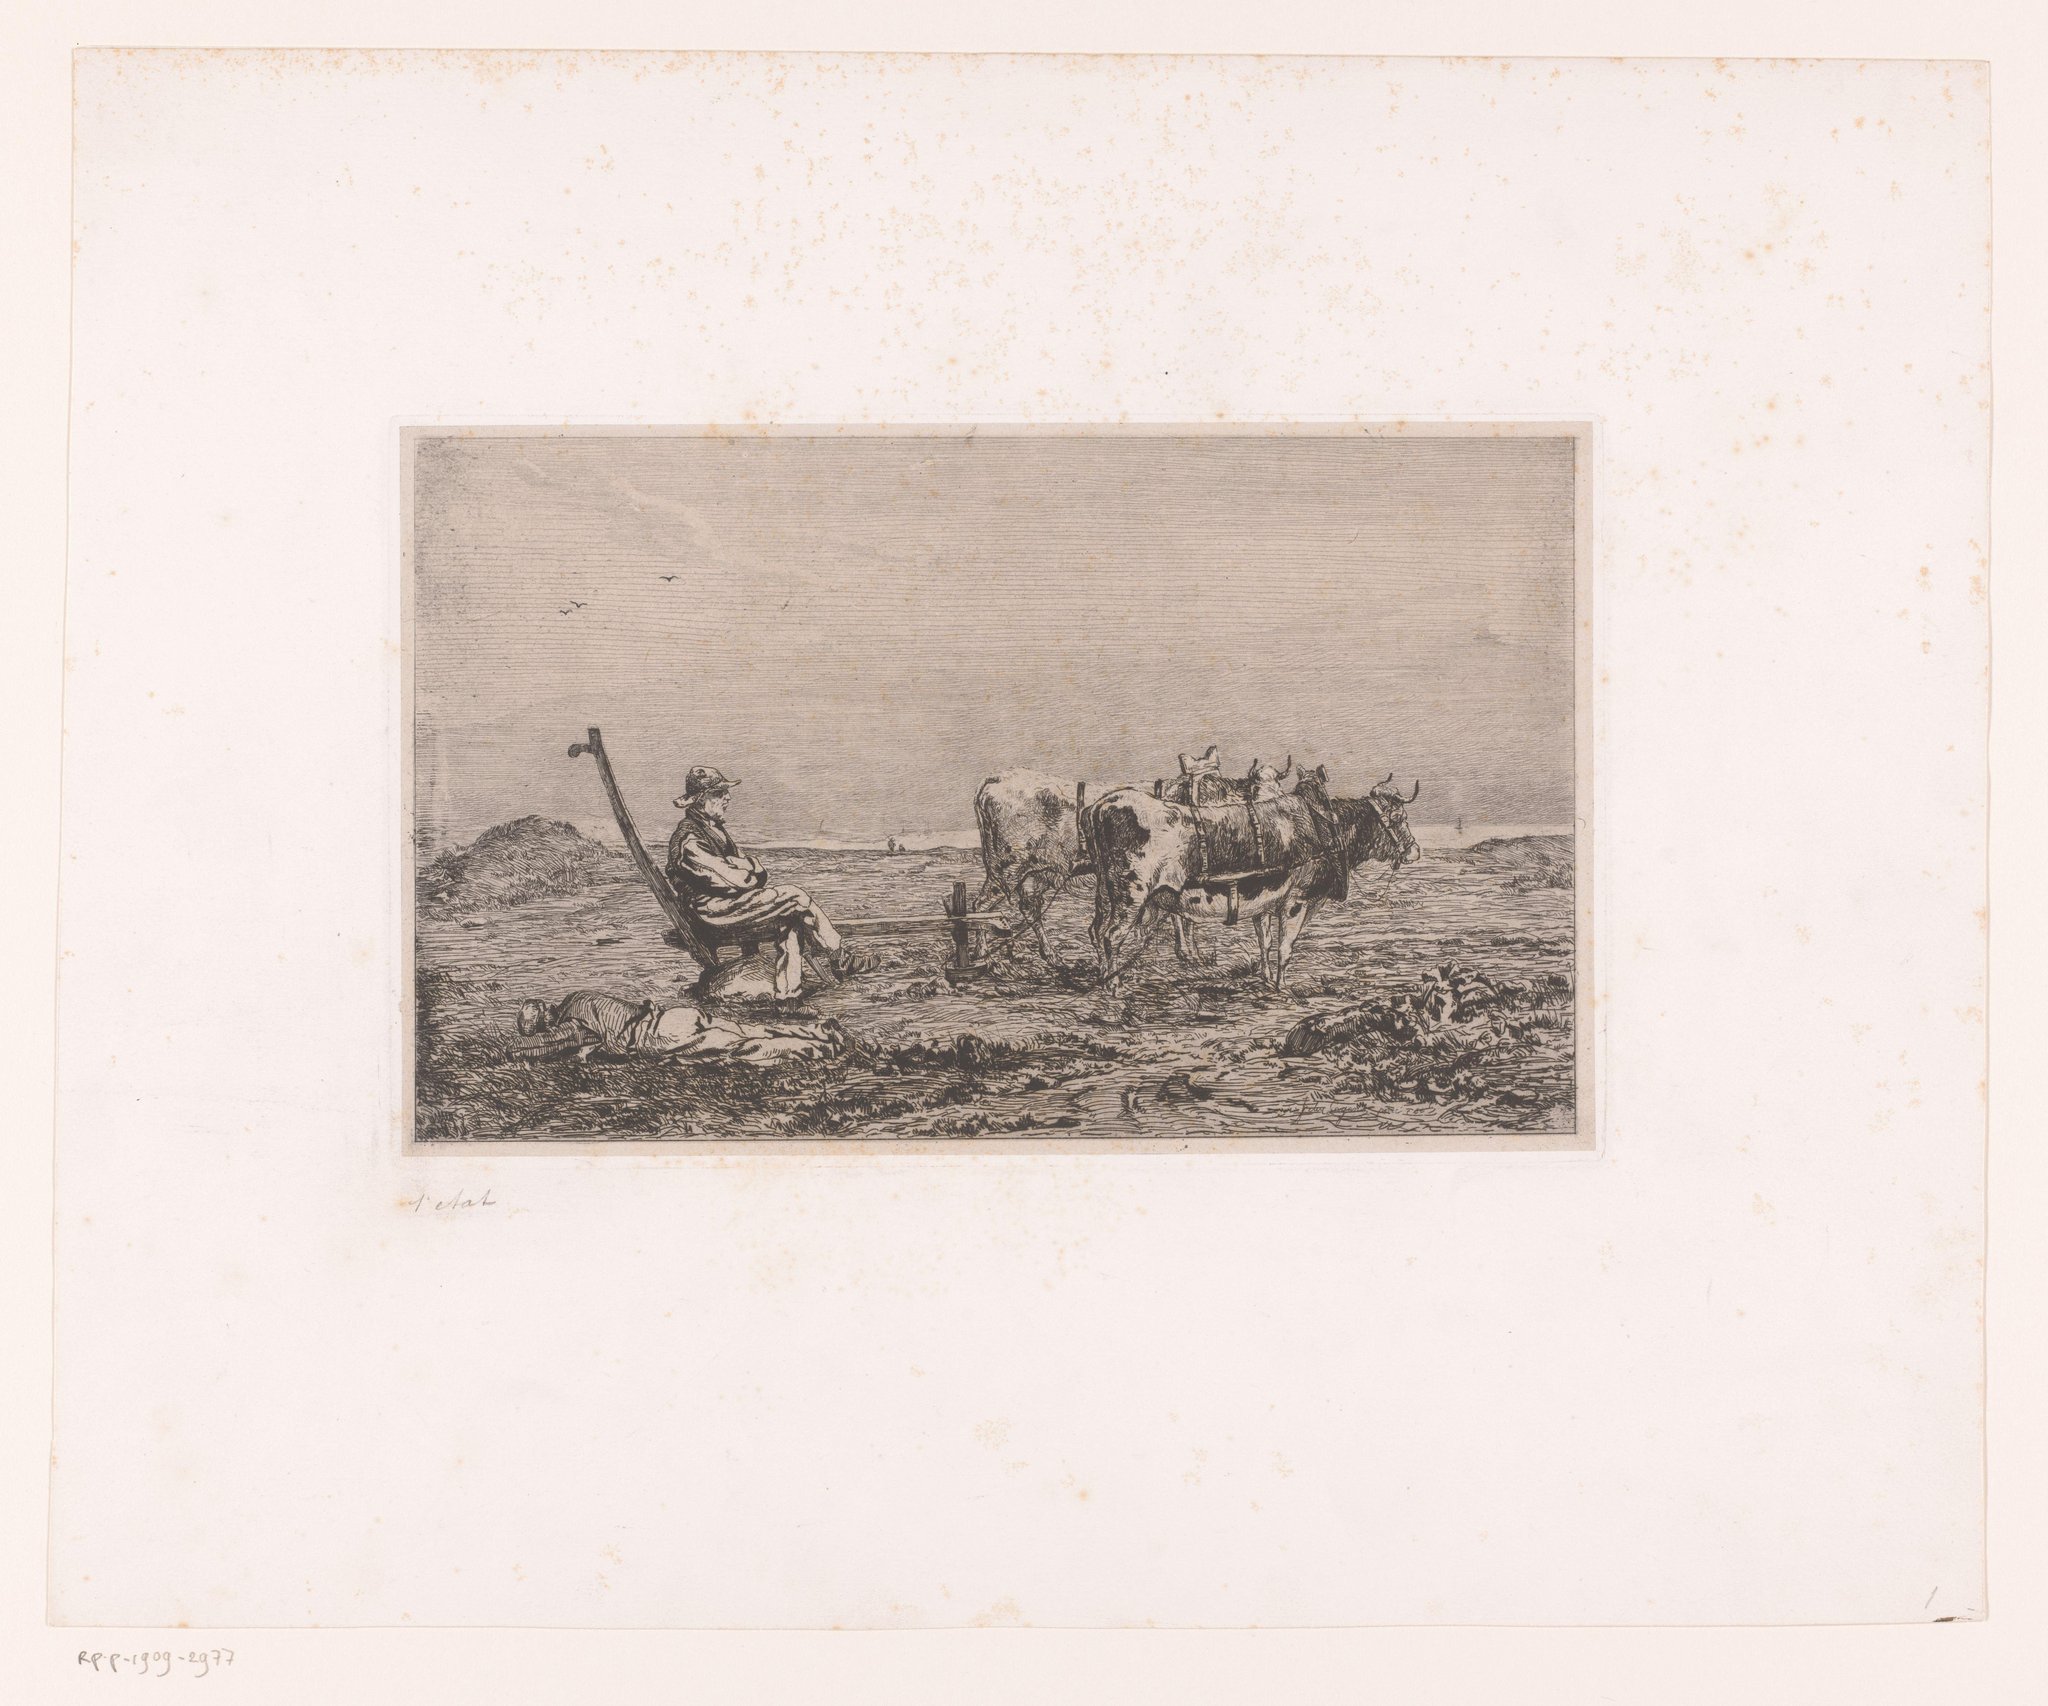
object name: print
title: Boeren op het land met een ploeg en twee runderen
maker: félix cogen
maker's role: print maker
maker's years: 1838-1907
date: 1848-1907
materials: paper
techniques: drypoint, etching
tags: farmers, agricultural implements: plough, bovine cattle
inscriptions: collector's mark: Lugt 2228